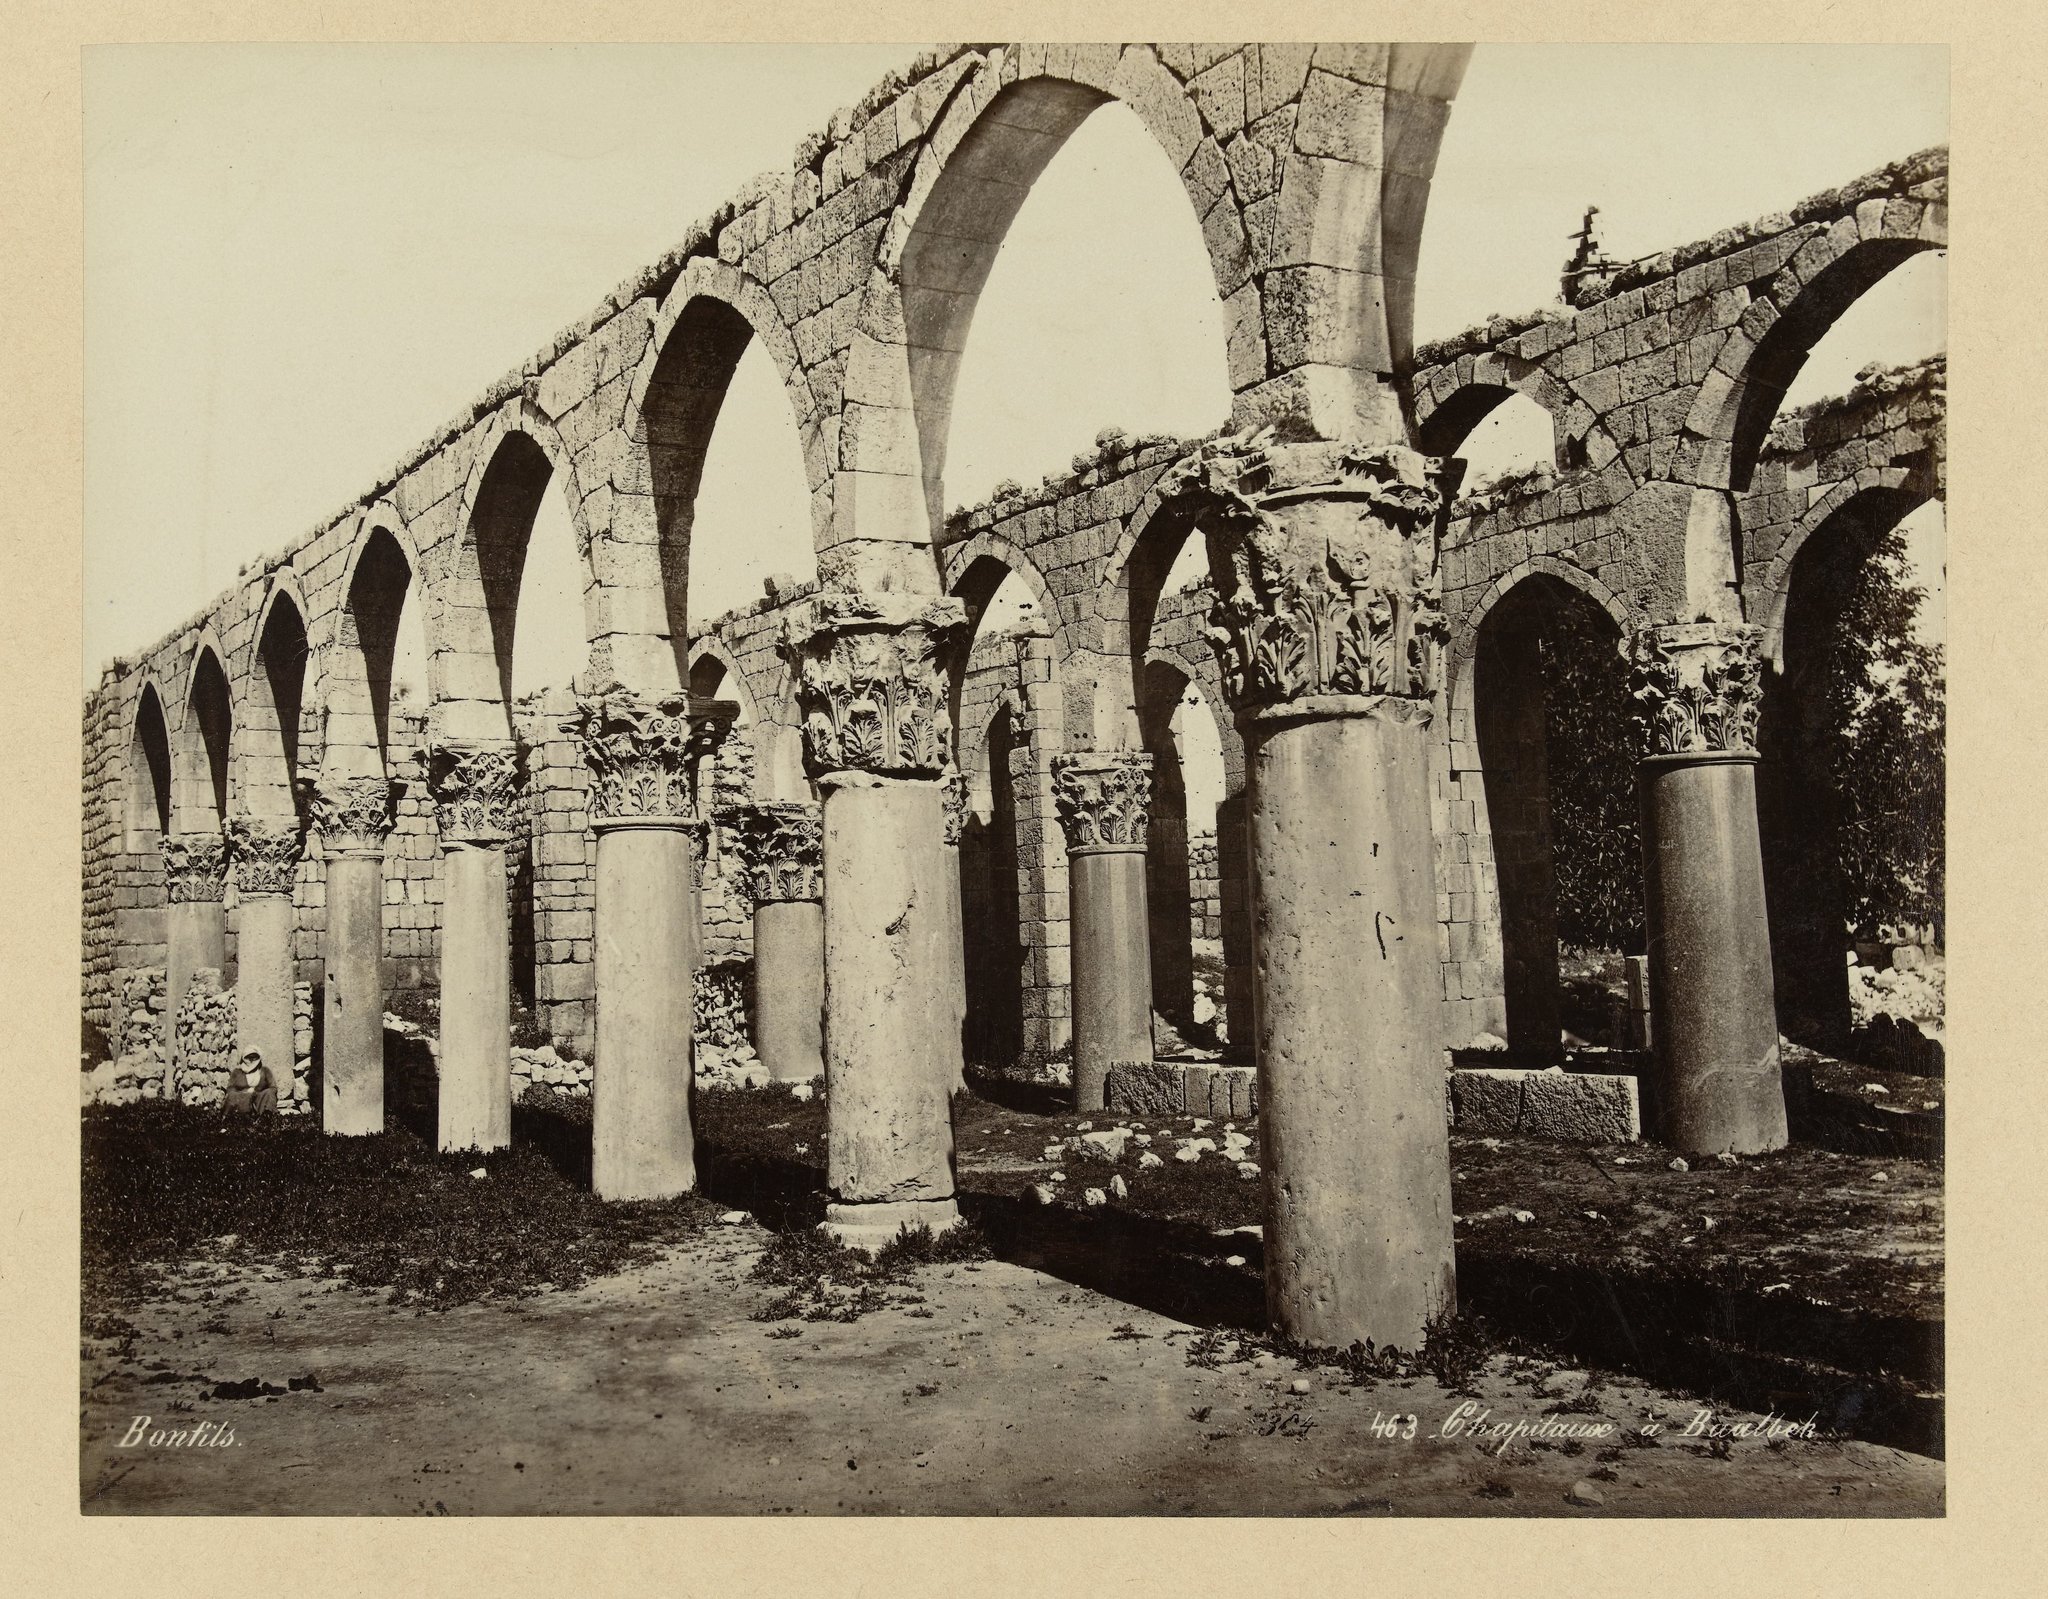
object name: photograph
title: S 80. Oude moskee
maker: félix bonfils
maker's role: fotograaf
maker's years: 1831-1885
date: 1867-1877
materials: cardboard, paper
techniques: albumen print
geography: baalbek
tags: ruin of a building ~ architecture, temple, shrine ~ islam, mohammedanism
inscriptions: check stamp: ‘Bristol/ L.M.’, number: ‘463’, stamp: ‘Gemeentelijke bibliotheek/ Rotterdam’, inscription: ‘S 80. Oude moskee./ Opgebouwd uit brokstukken van den tempel van Jupiter. Baalbec./ Syrië.’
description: Onderdeel van een groep door fotograaf Richard Polak op reis verzamelde foto’s. Deze foto is samen met andere op zijn reizen verzamelde foto's tentoongesteld bij de Rotterdamsche Kunstkring (1895), Arti en Amicitiae te Amsterdam (1897-1898?) en Societeit 't Collegie te Kampen (datum vooralsnog onbekend).